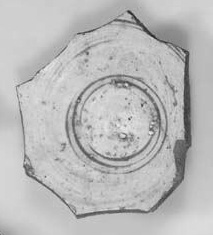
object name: shard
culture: korean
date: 1401-1500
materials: pottery